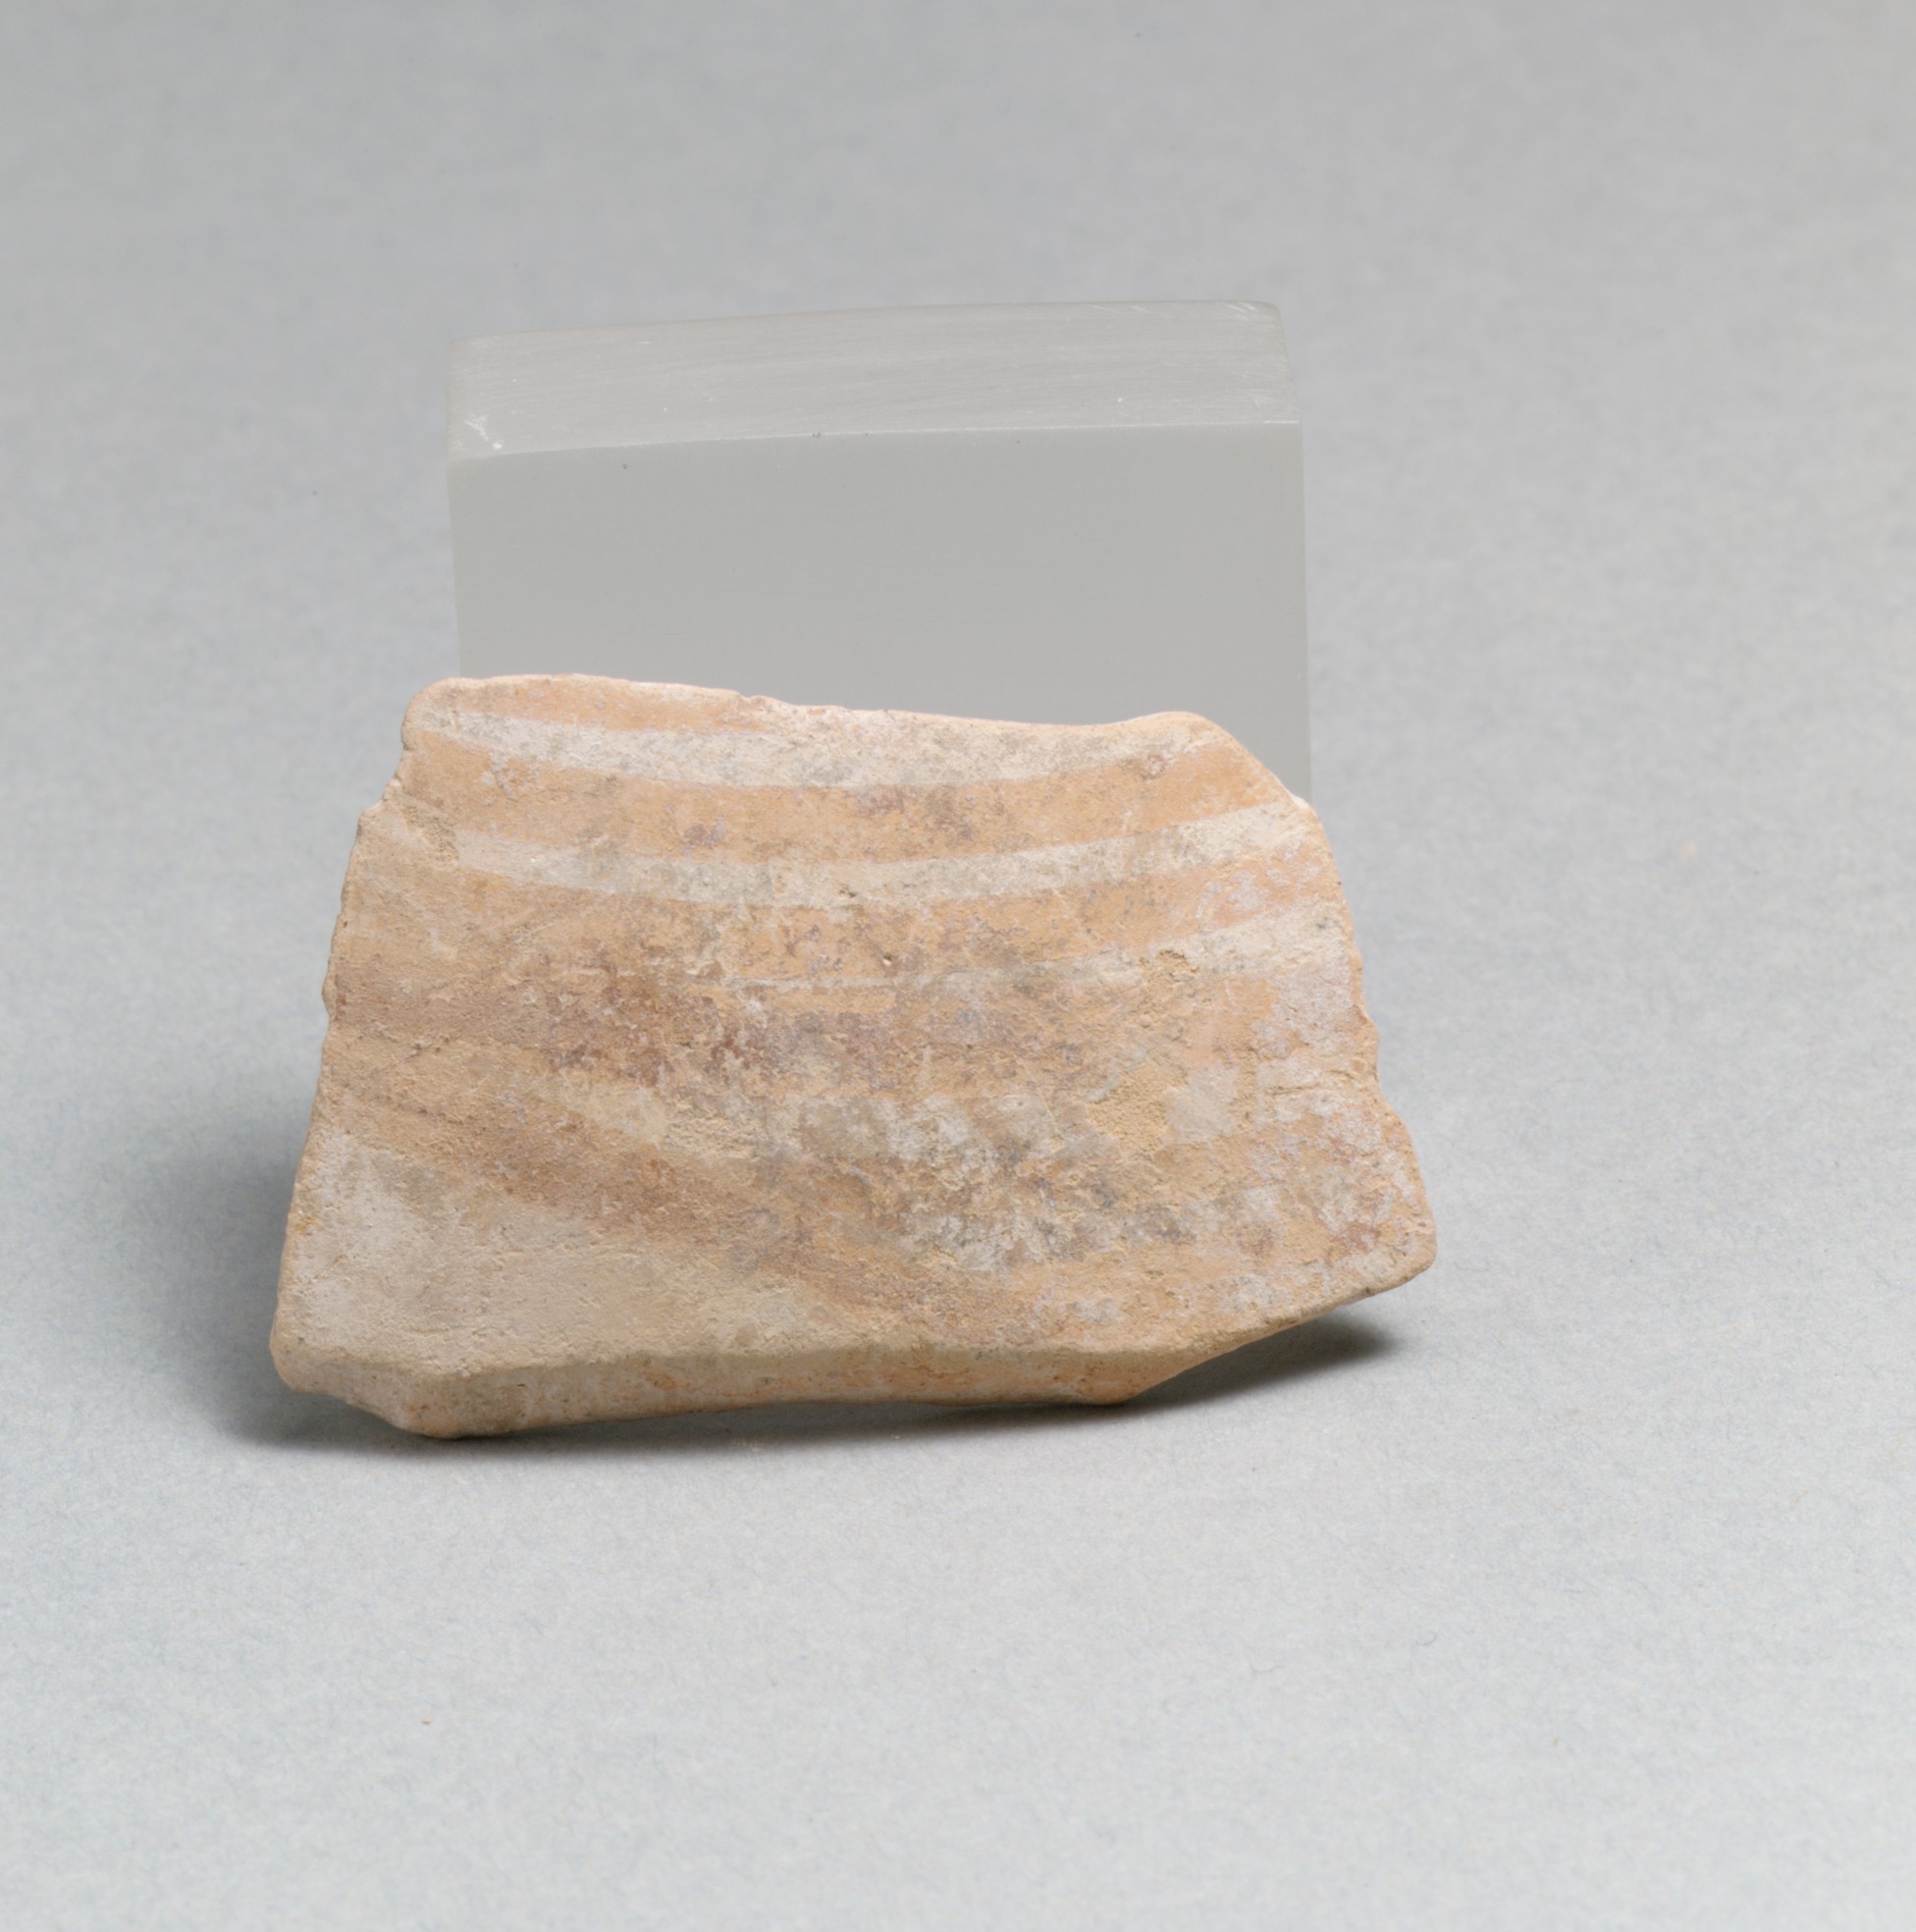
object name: vase fragment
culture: minoan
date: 2600-2000 BCE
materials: terracotta